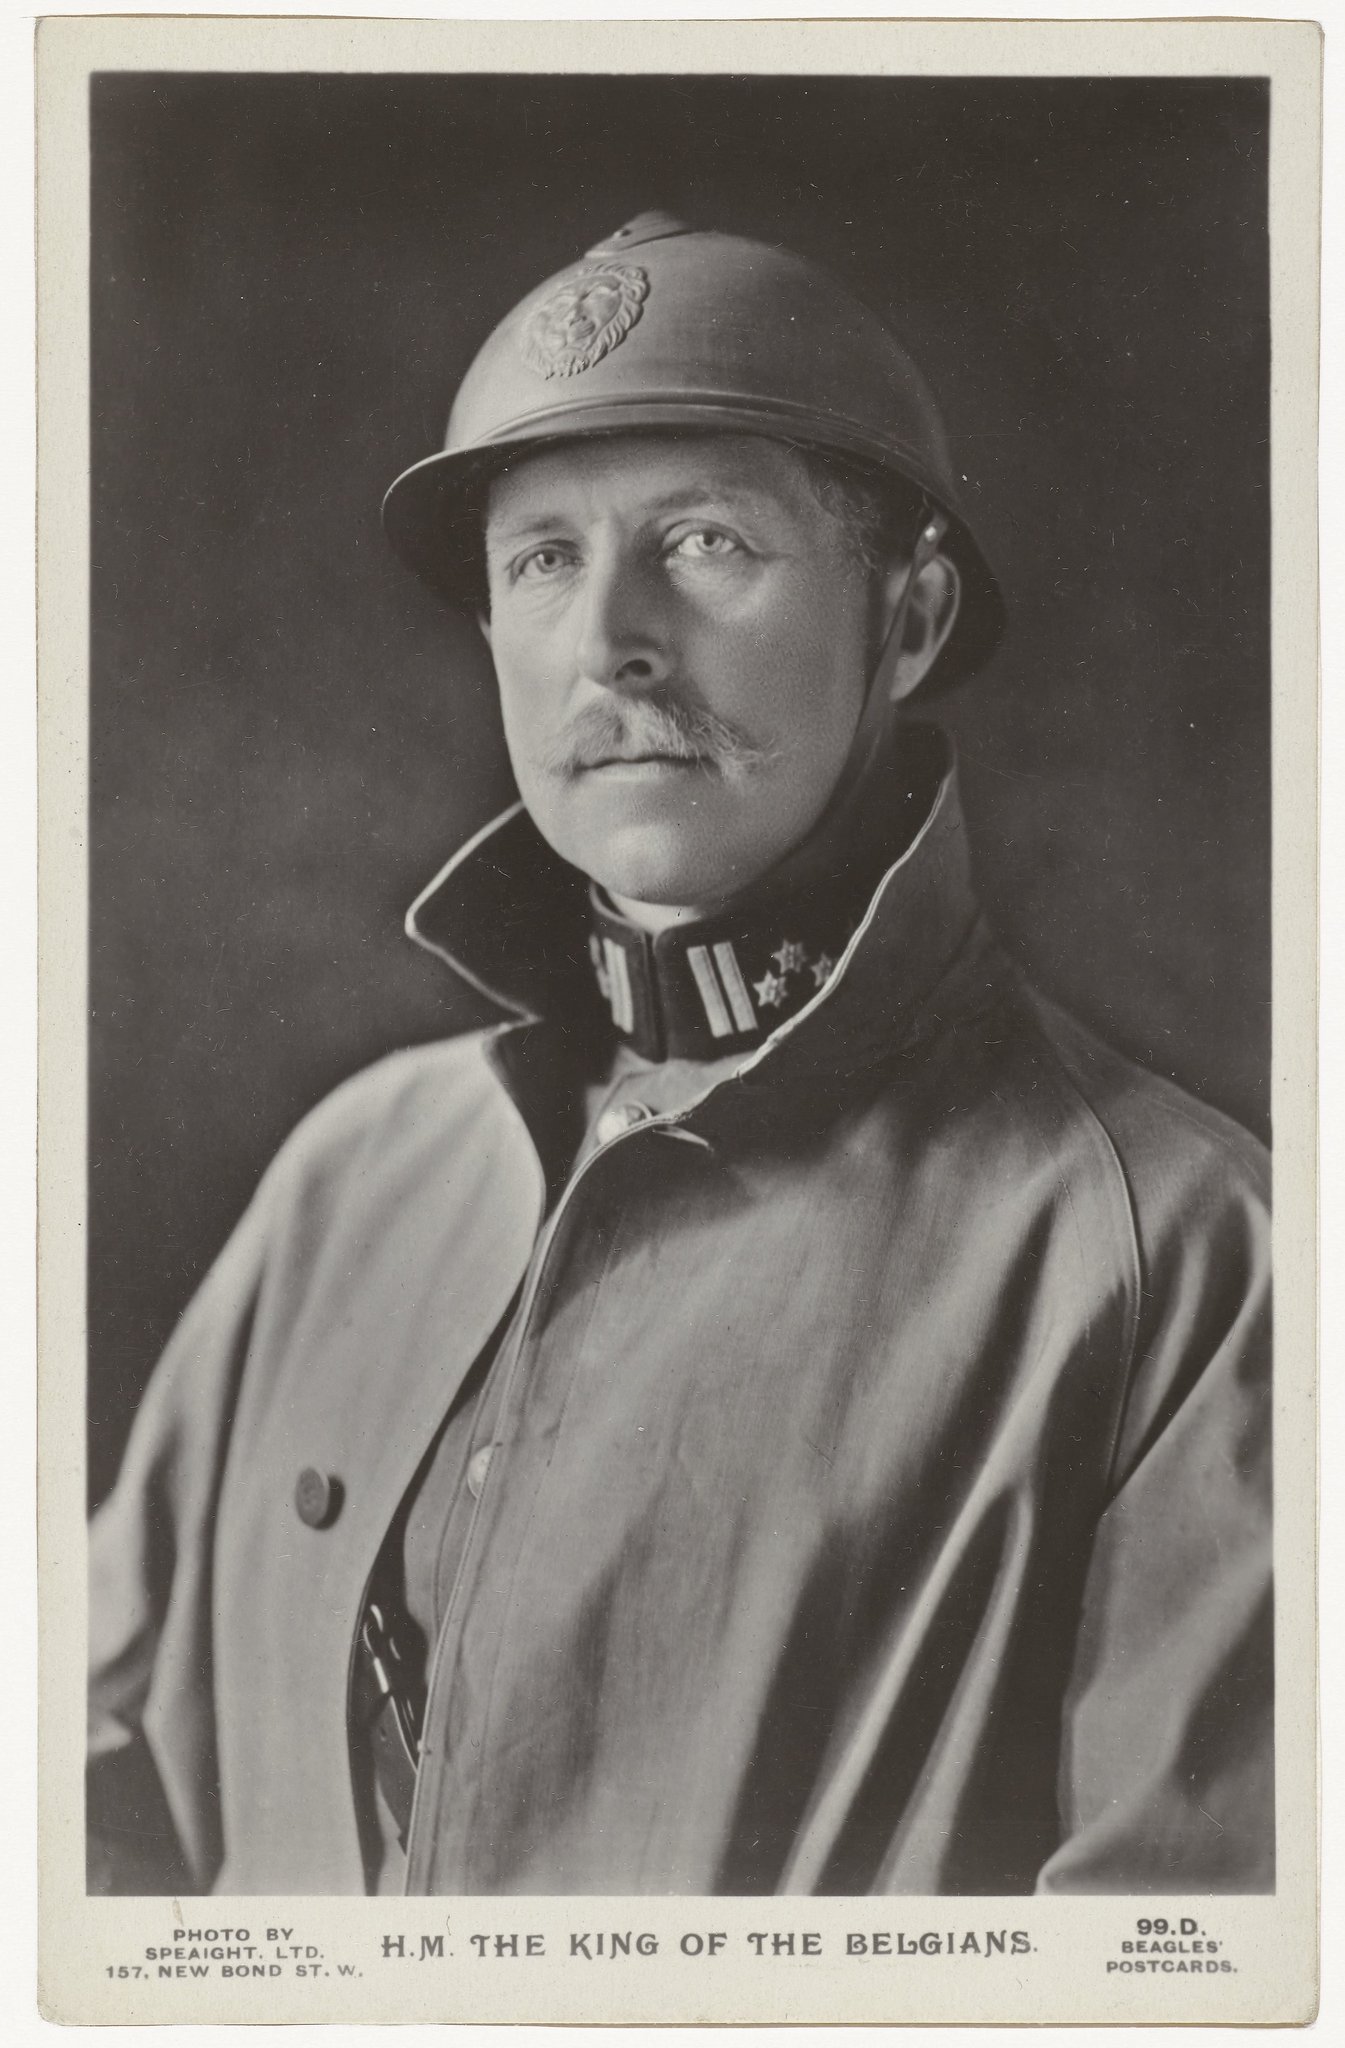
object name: ansichtkaart, prentbriefkaart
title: H.M. the King of the Belgians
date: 1914-1918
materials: paper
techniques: gelatin silver print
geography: london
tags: historical persons, king, europe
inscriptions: address: ‘187. NEW BOND ST. W.’, inscription: ‘J. BEAGLES & Co Ltd. E.C. Printers & Publishers./ GUARANTEED REAL PHOTOGRAPH.’, number: ‘99D.’